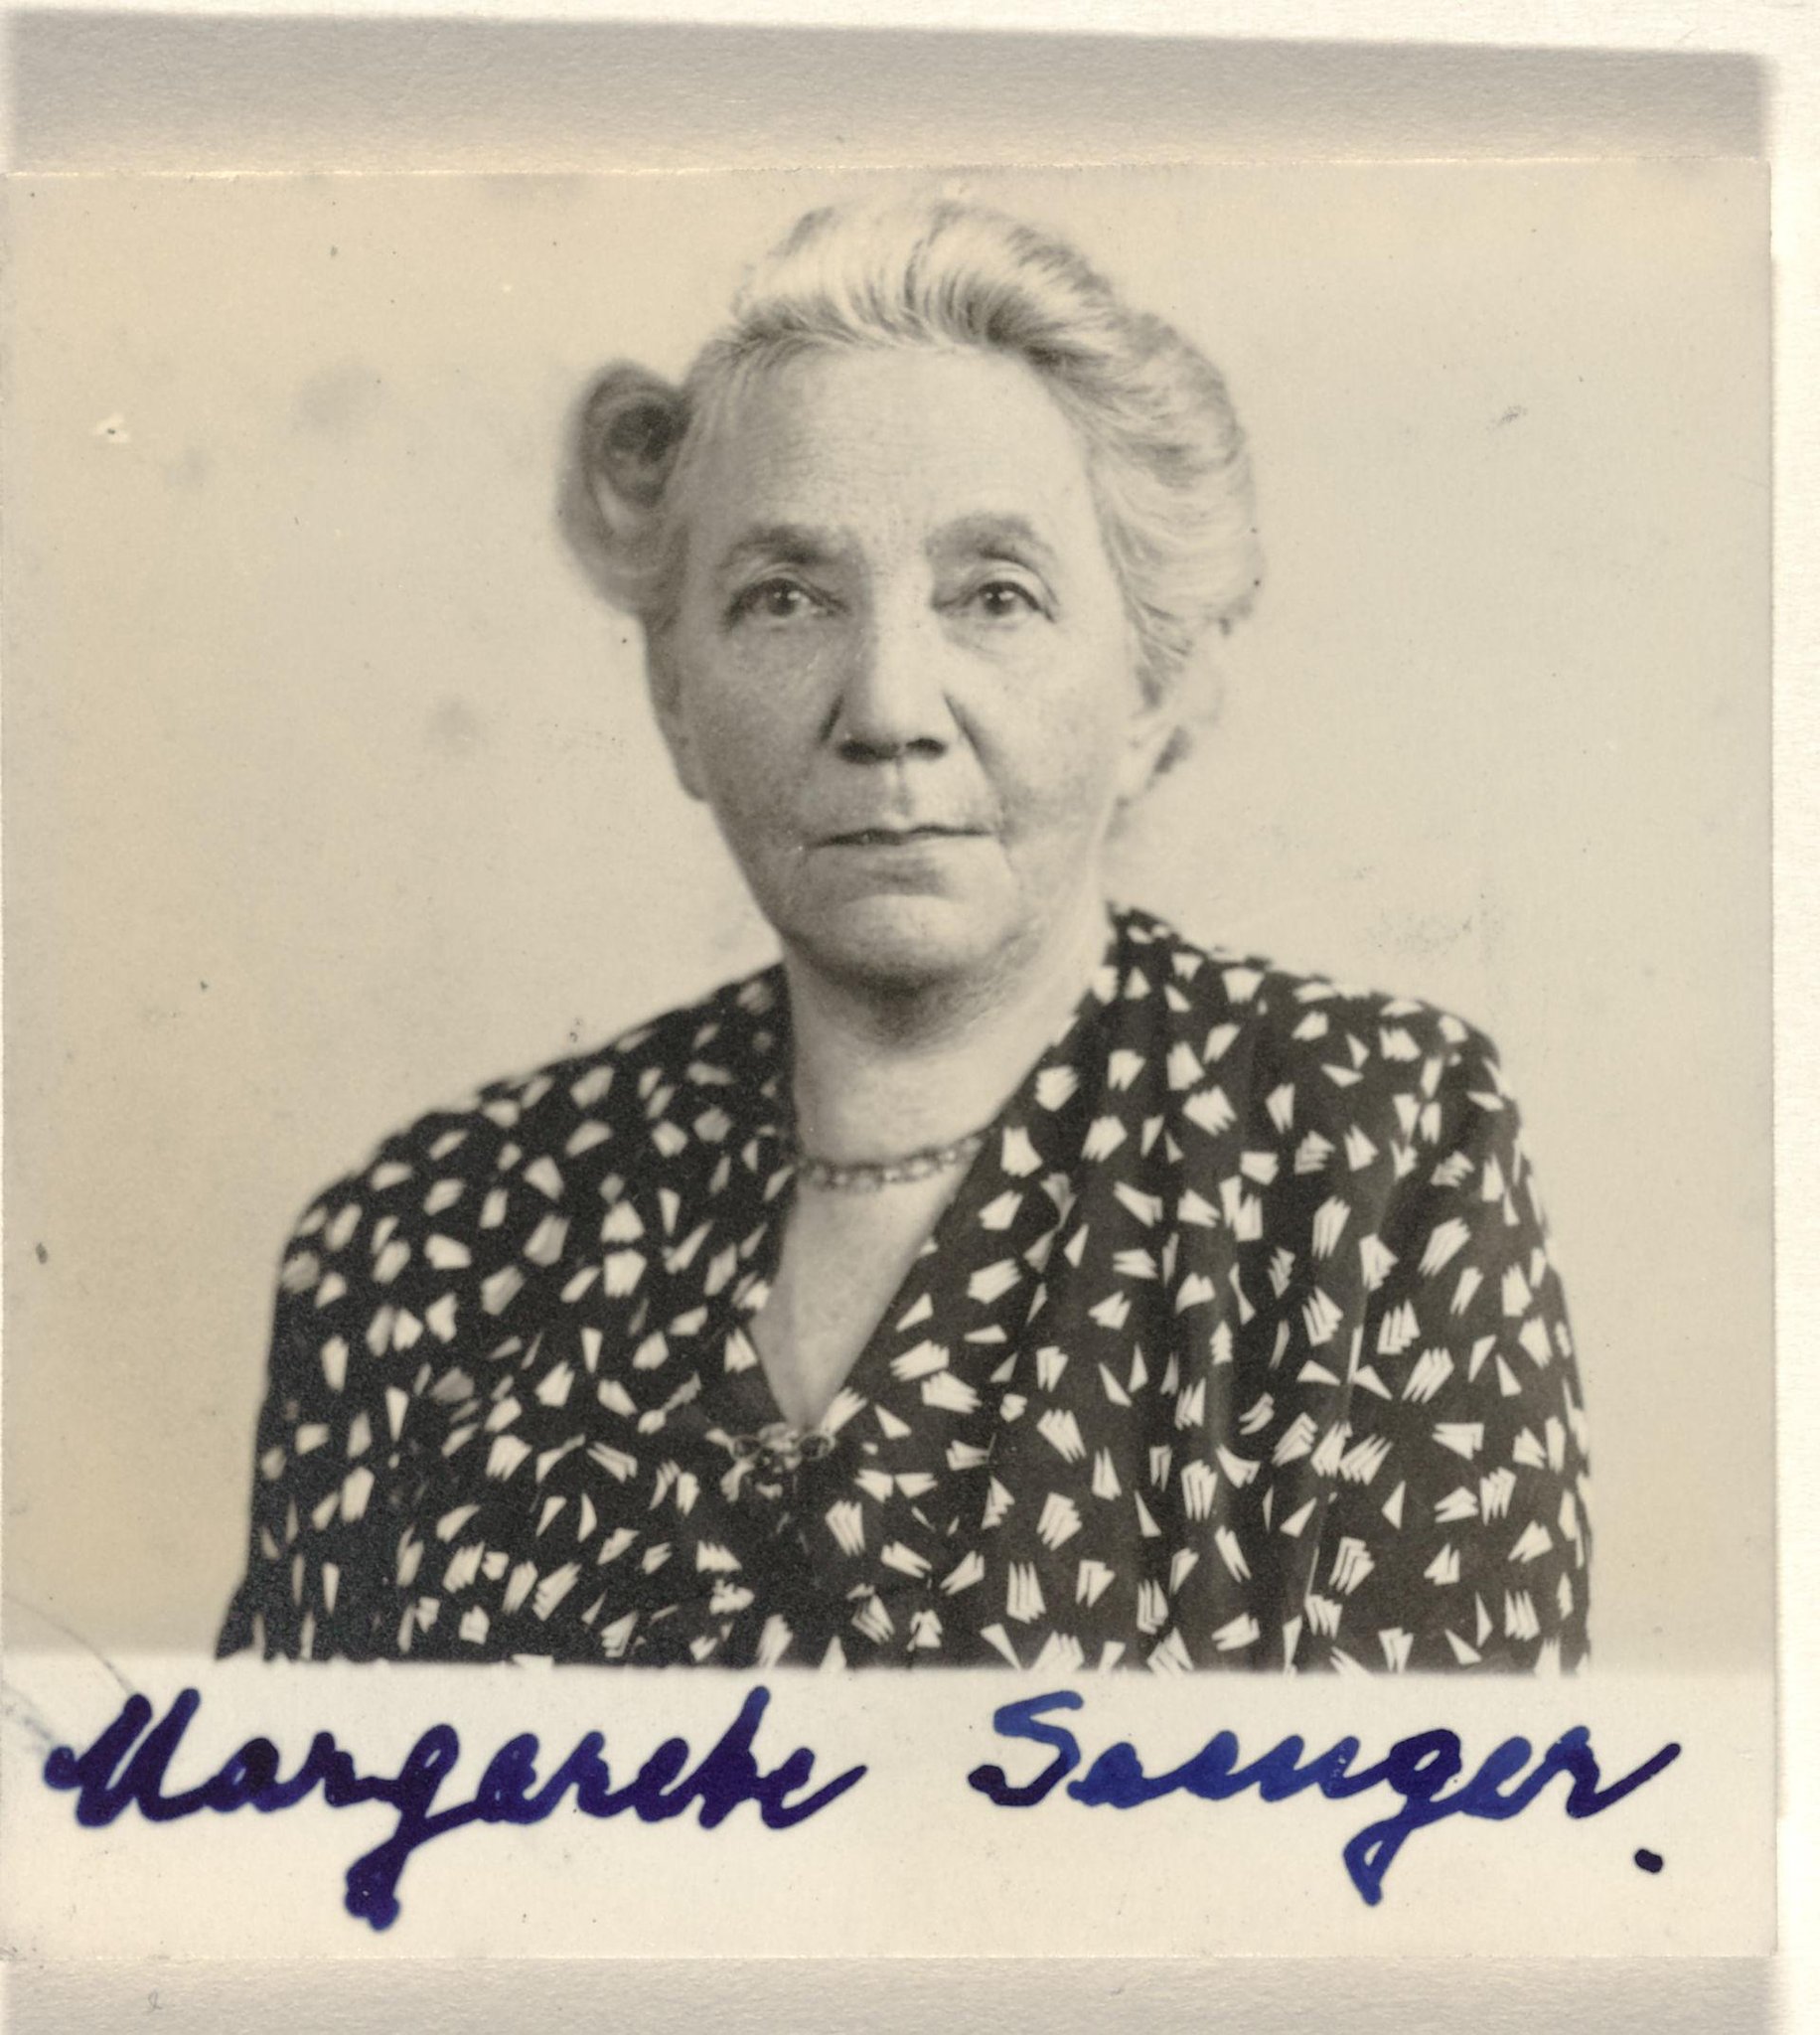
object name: photograph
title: Portret van Margarete Sänger, in gestipte kleding met opschrift op de voorzijde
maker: Anonymous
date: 1906-1947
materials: photographic support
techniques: gelatin silver print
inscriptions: inscription: ‘mein Passbild Juni 1947’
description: Portret van Margarete Sänger, in gestipte kleding.